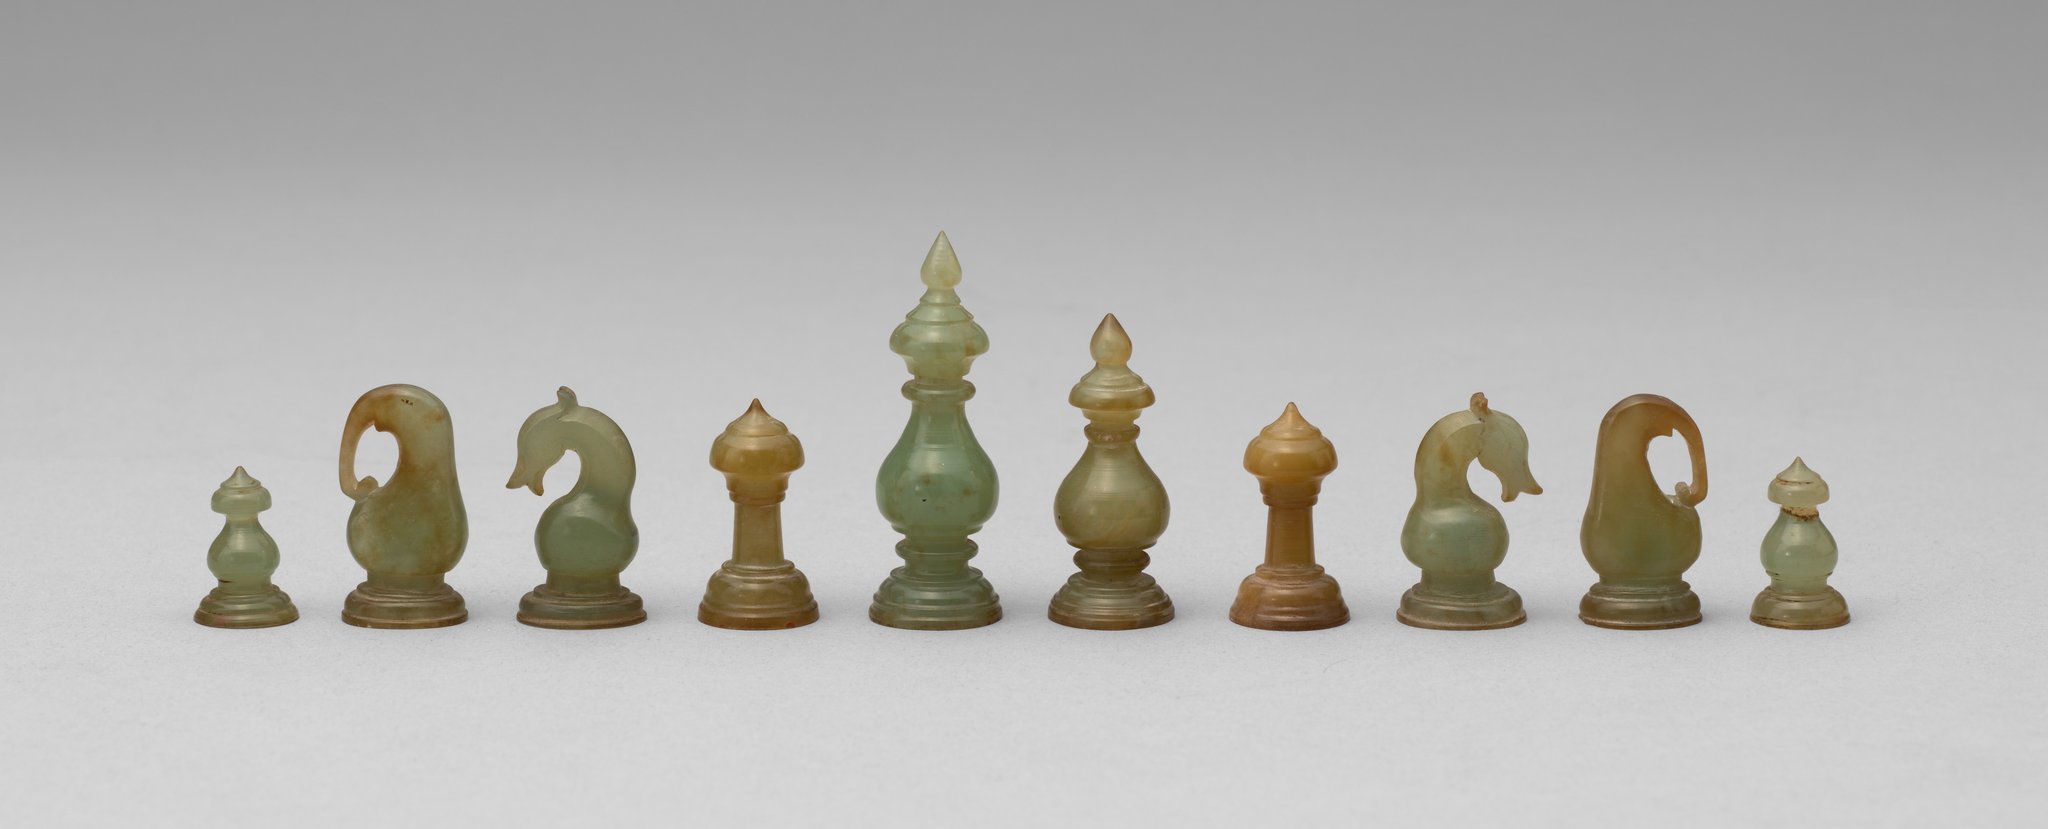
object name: chessman and box board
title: Chessmen (32) and board with box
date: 1701-1900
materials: bronze, jade, marble, mother of pearl, onyx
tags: chess